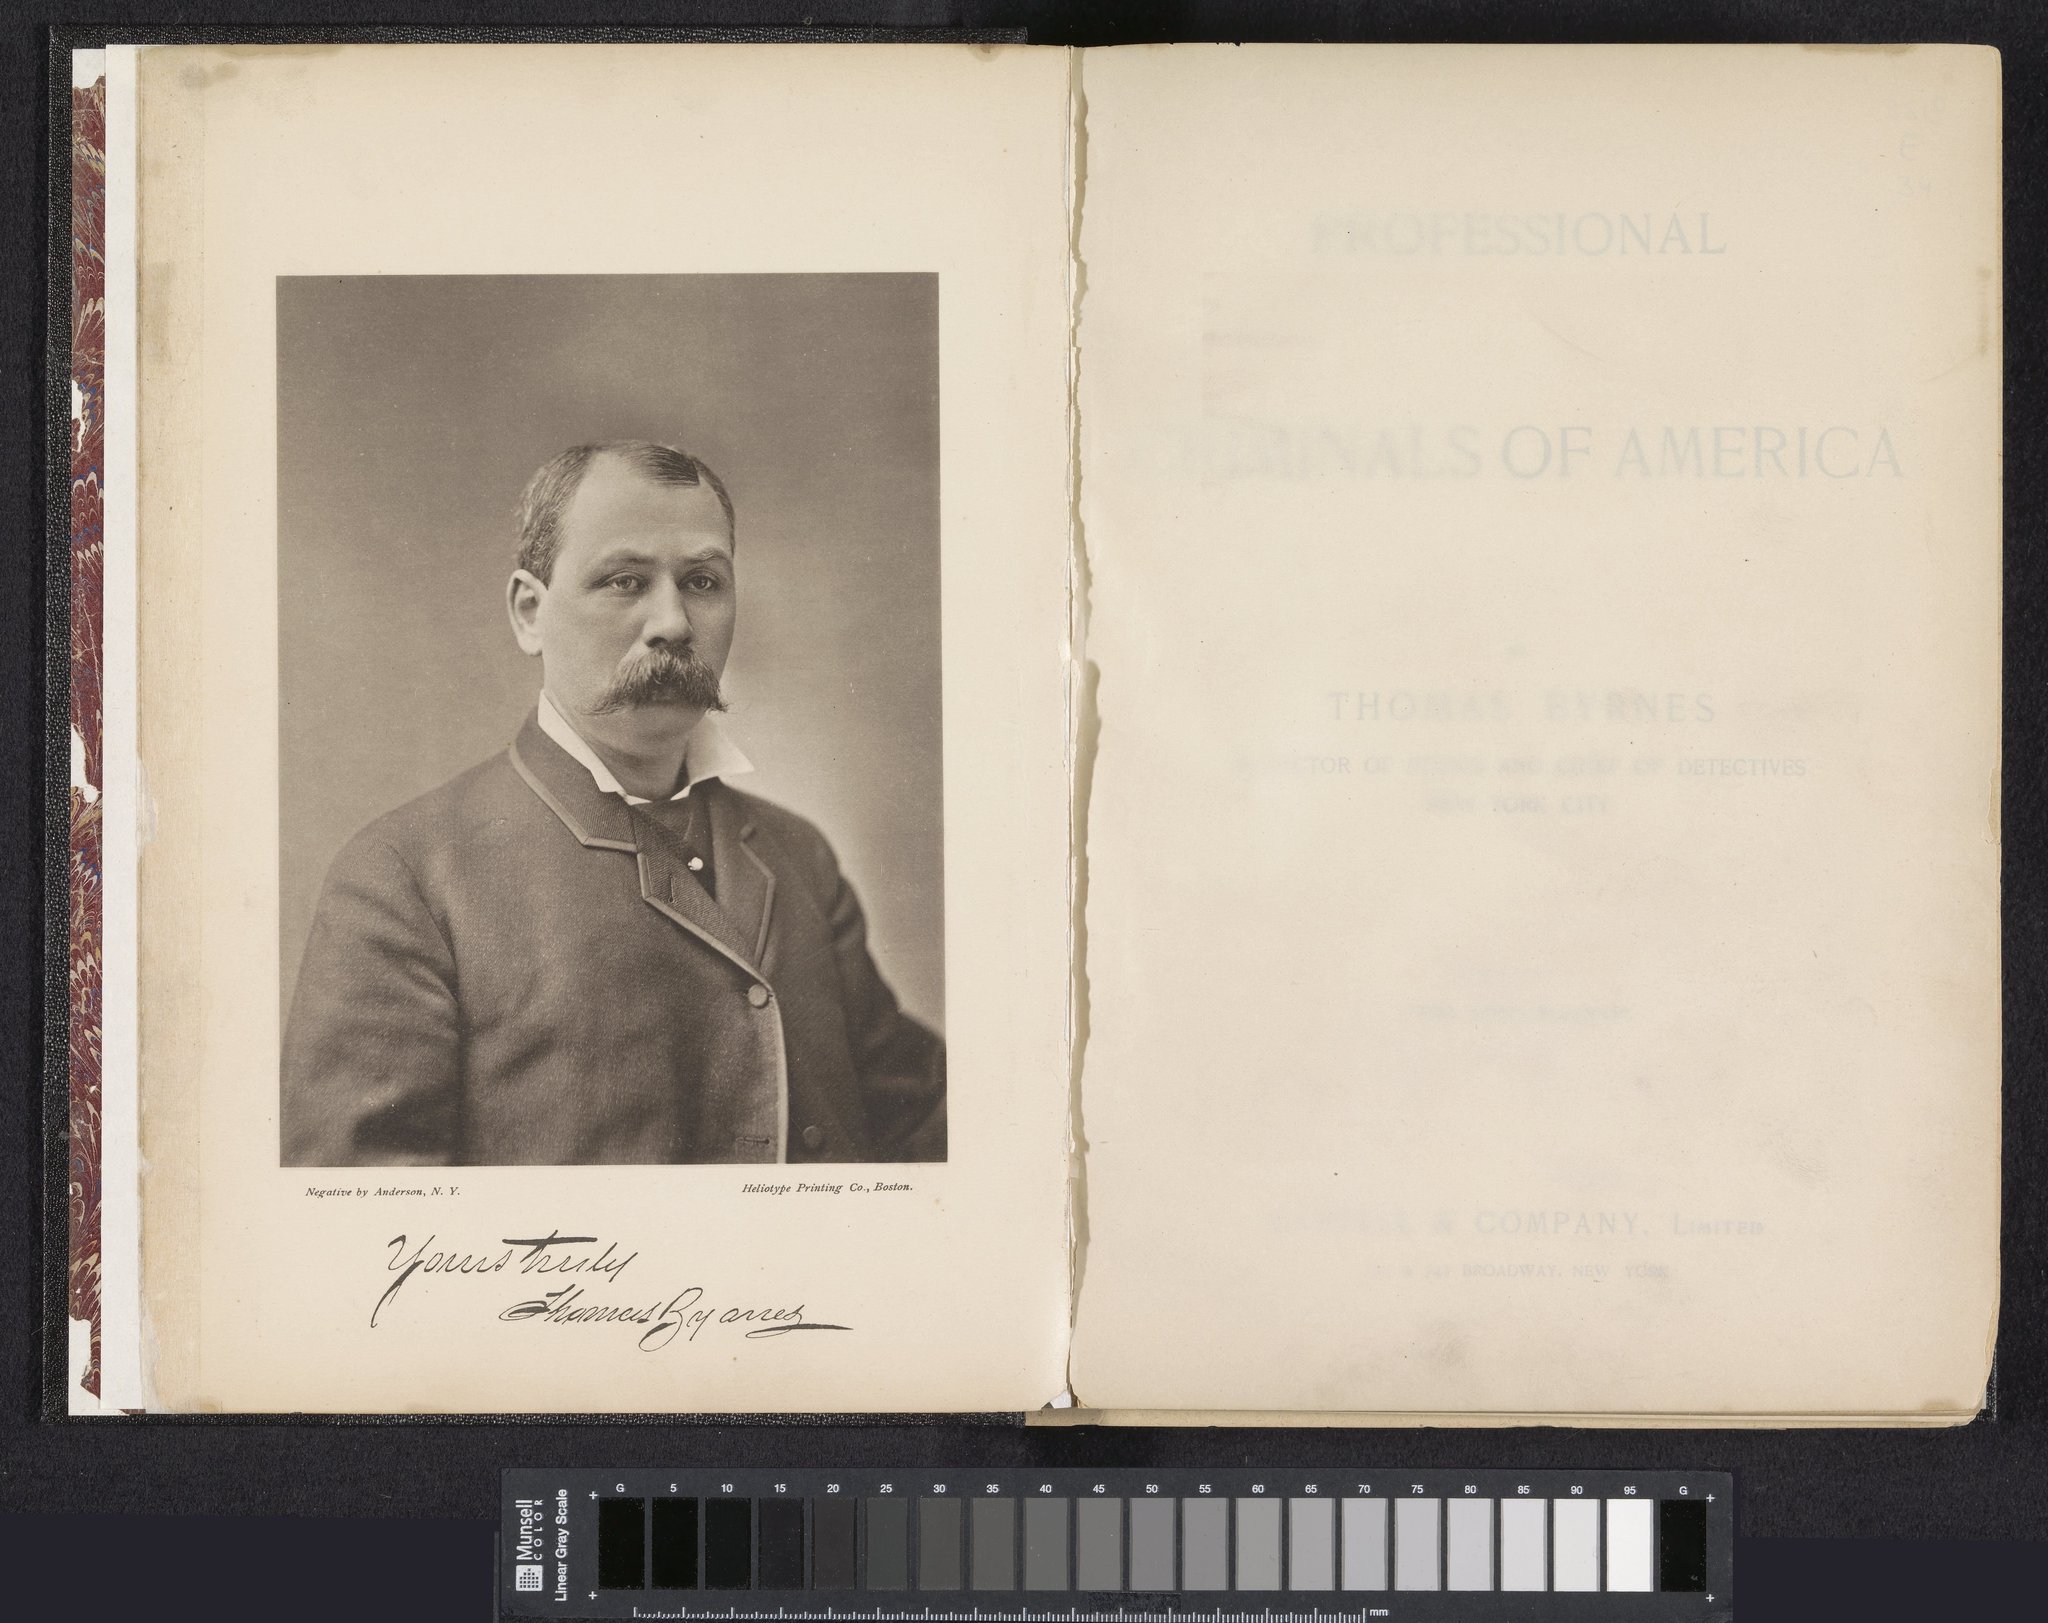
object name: photomechanical print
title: Portret van Thomas F. Byrnes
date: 1881-1886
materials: paper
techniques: photograph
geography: boston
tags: thomas f. byrnes, portrait of a writer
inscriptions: inscription: ‘Yours Truly Thomas Byrnes’